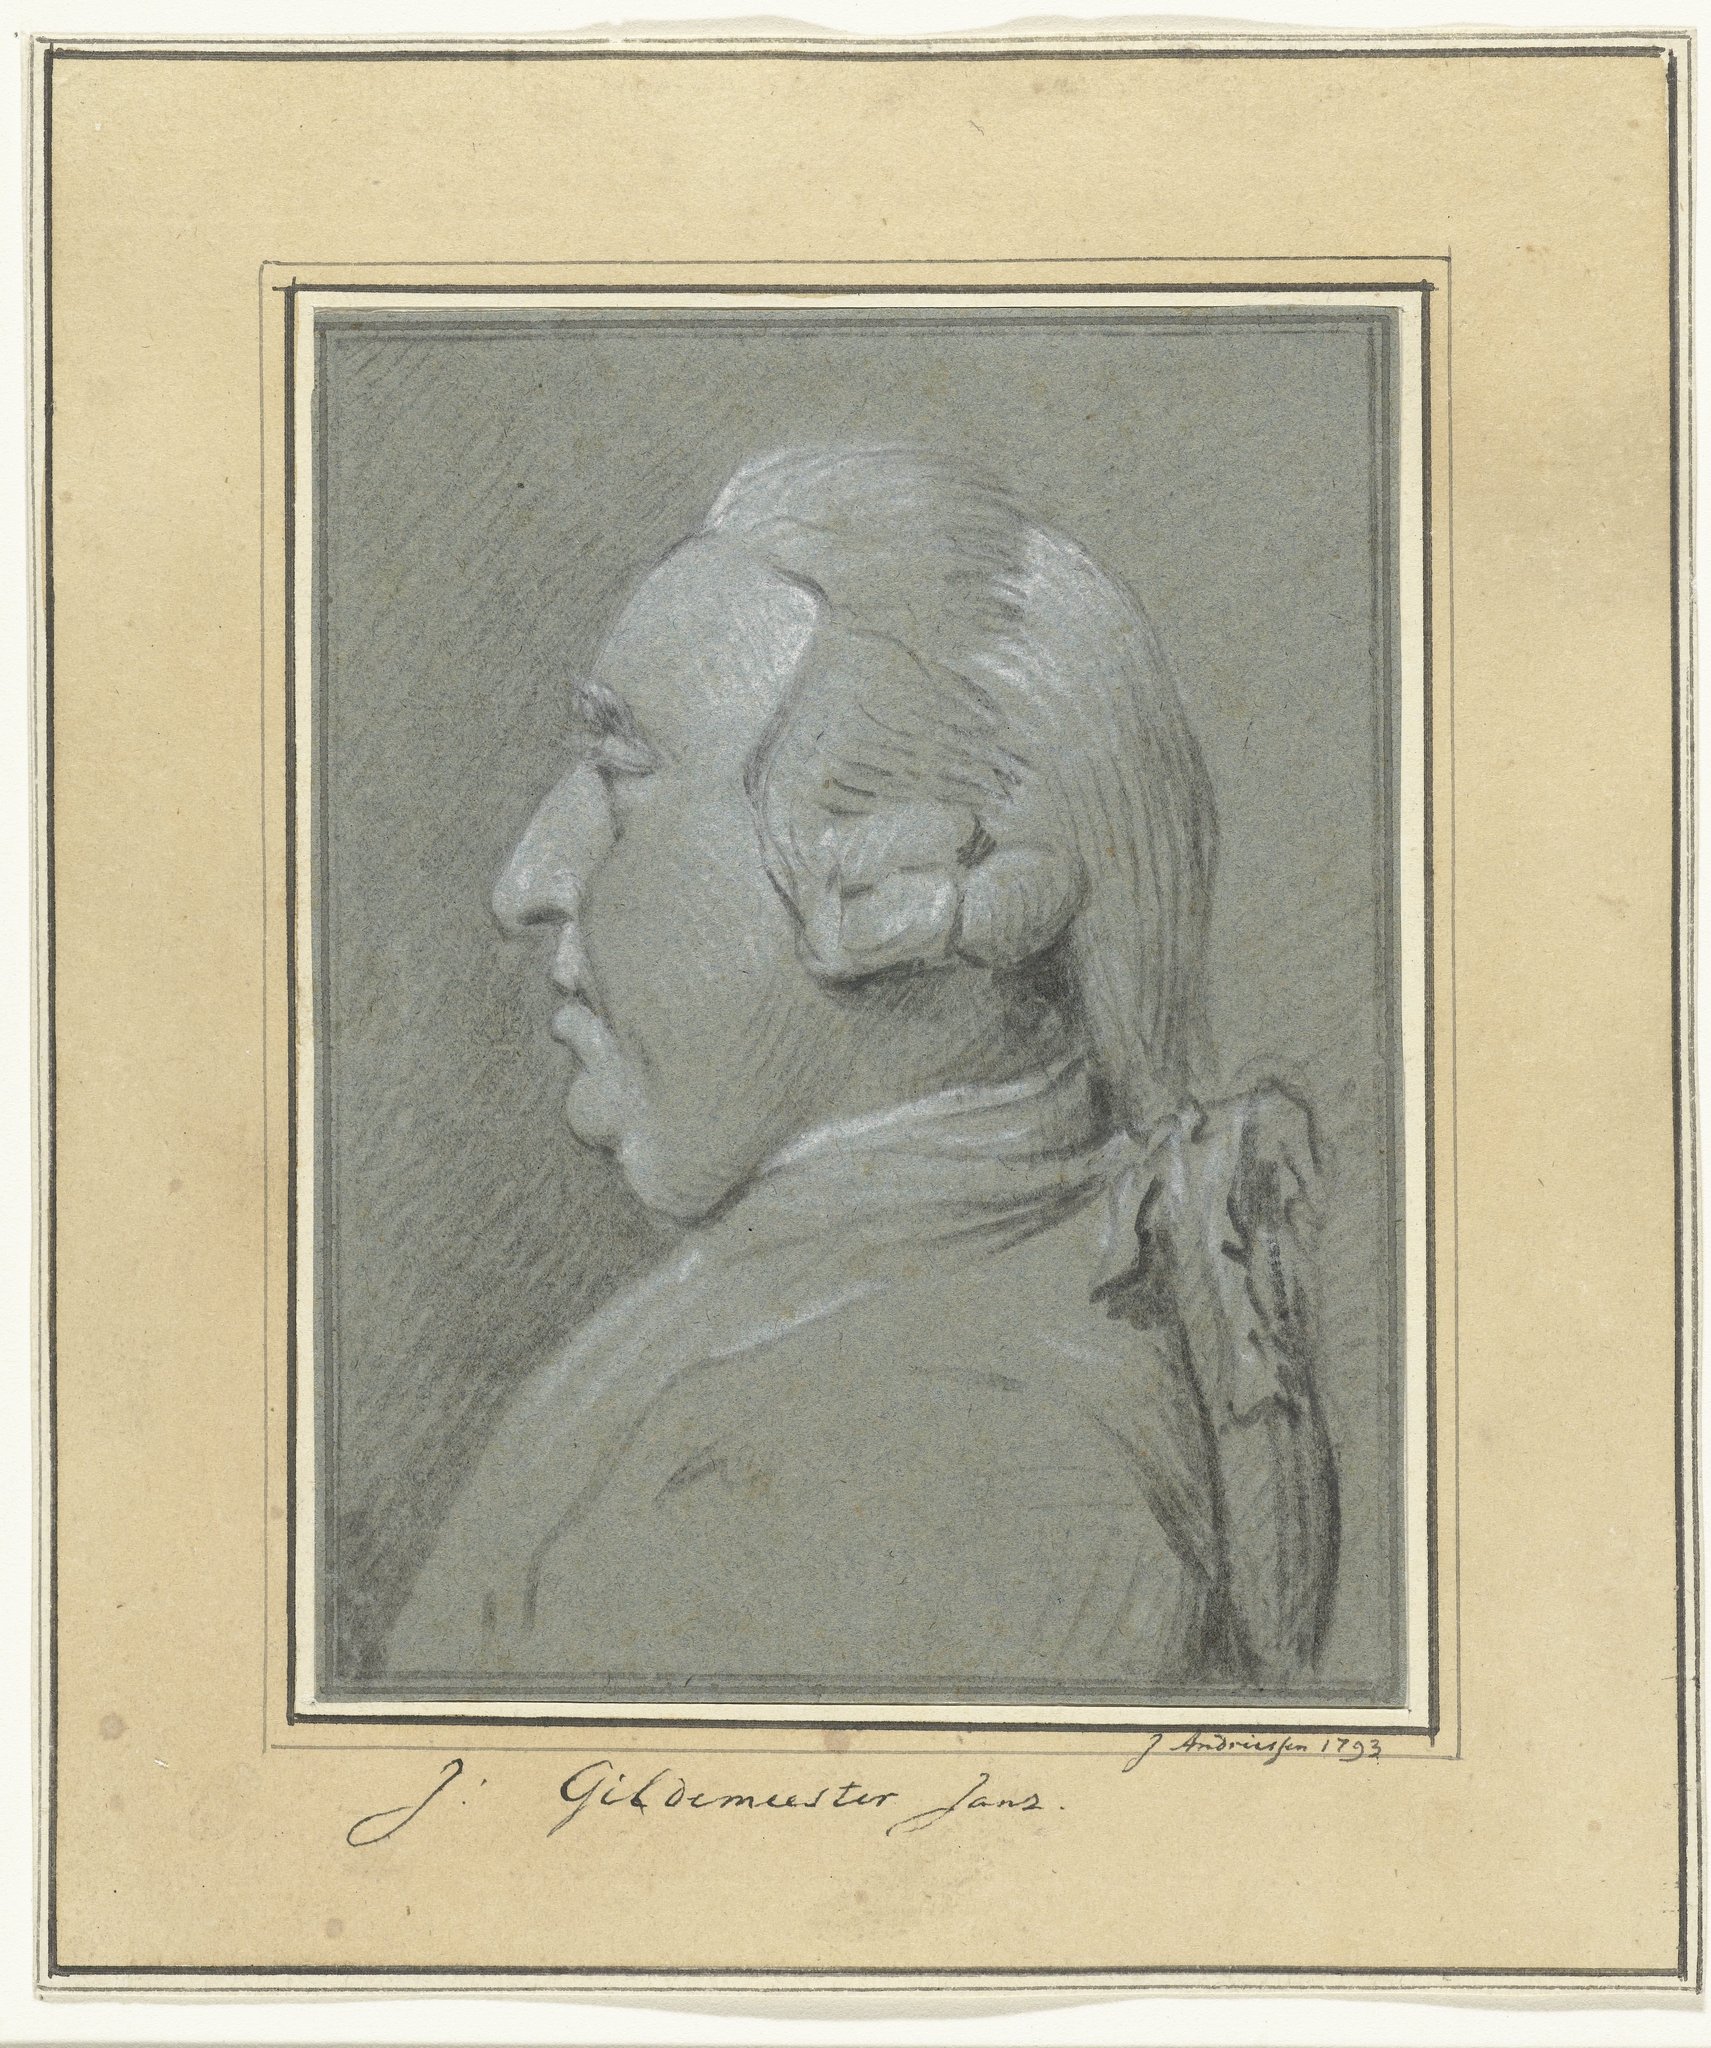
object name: drawing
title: Portret van Jan Gildemeester Jansz.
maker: jurriaan andriessen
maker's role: draughtsman, painter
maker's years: 1742-1819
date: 1793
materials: chalk, paper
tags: historical persons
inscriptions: date: ‘1793’, date: ‘18 febr. 1793’